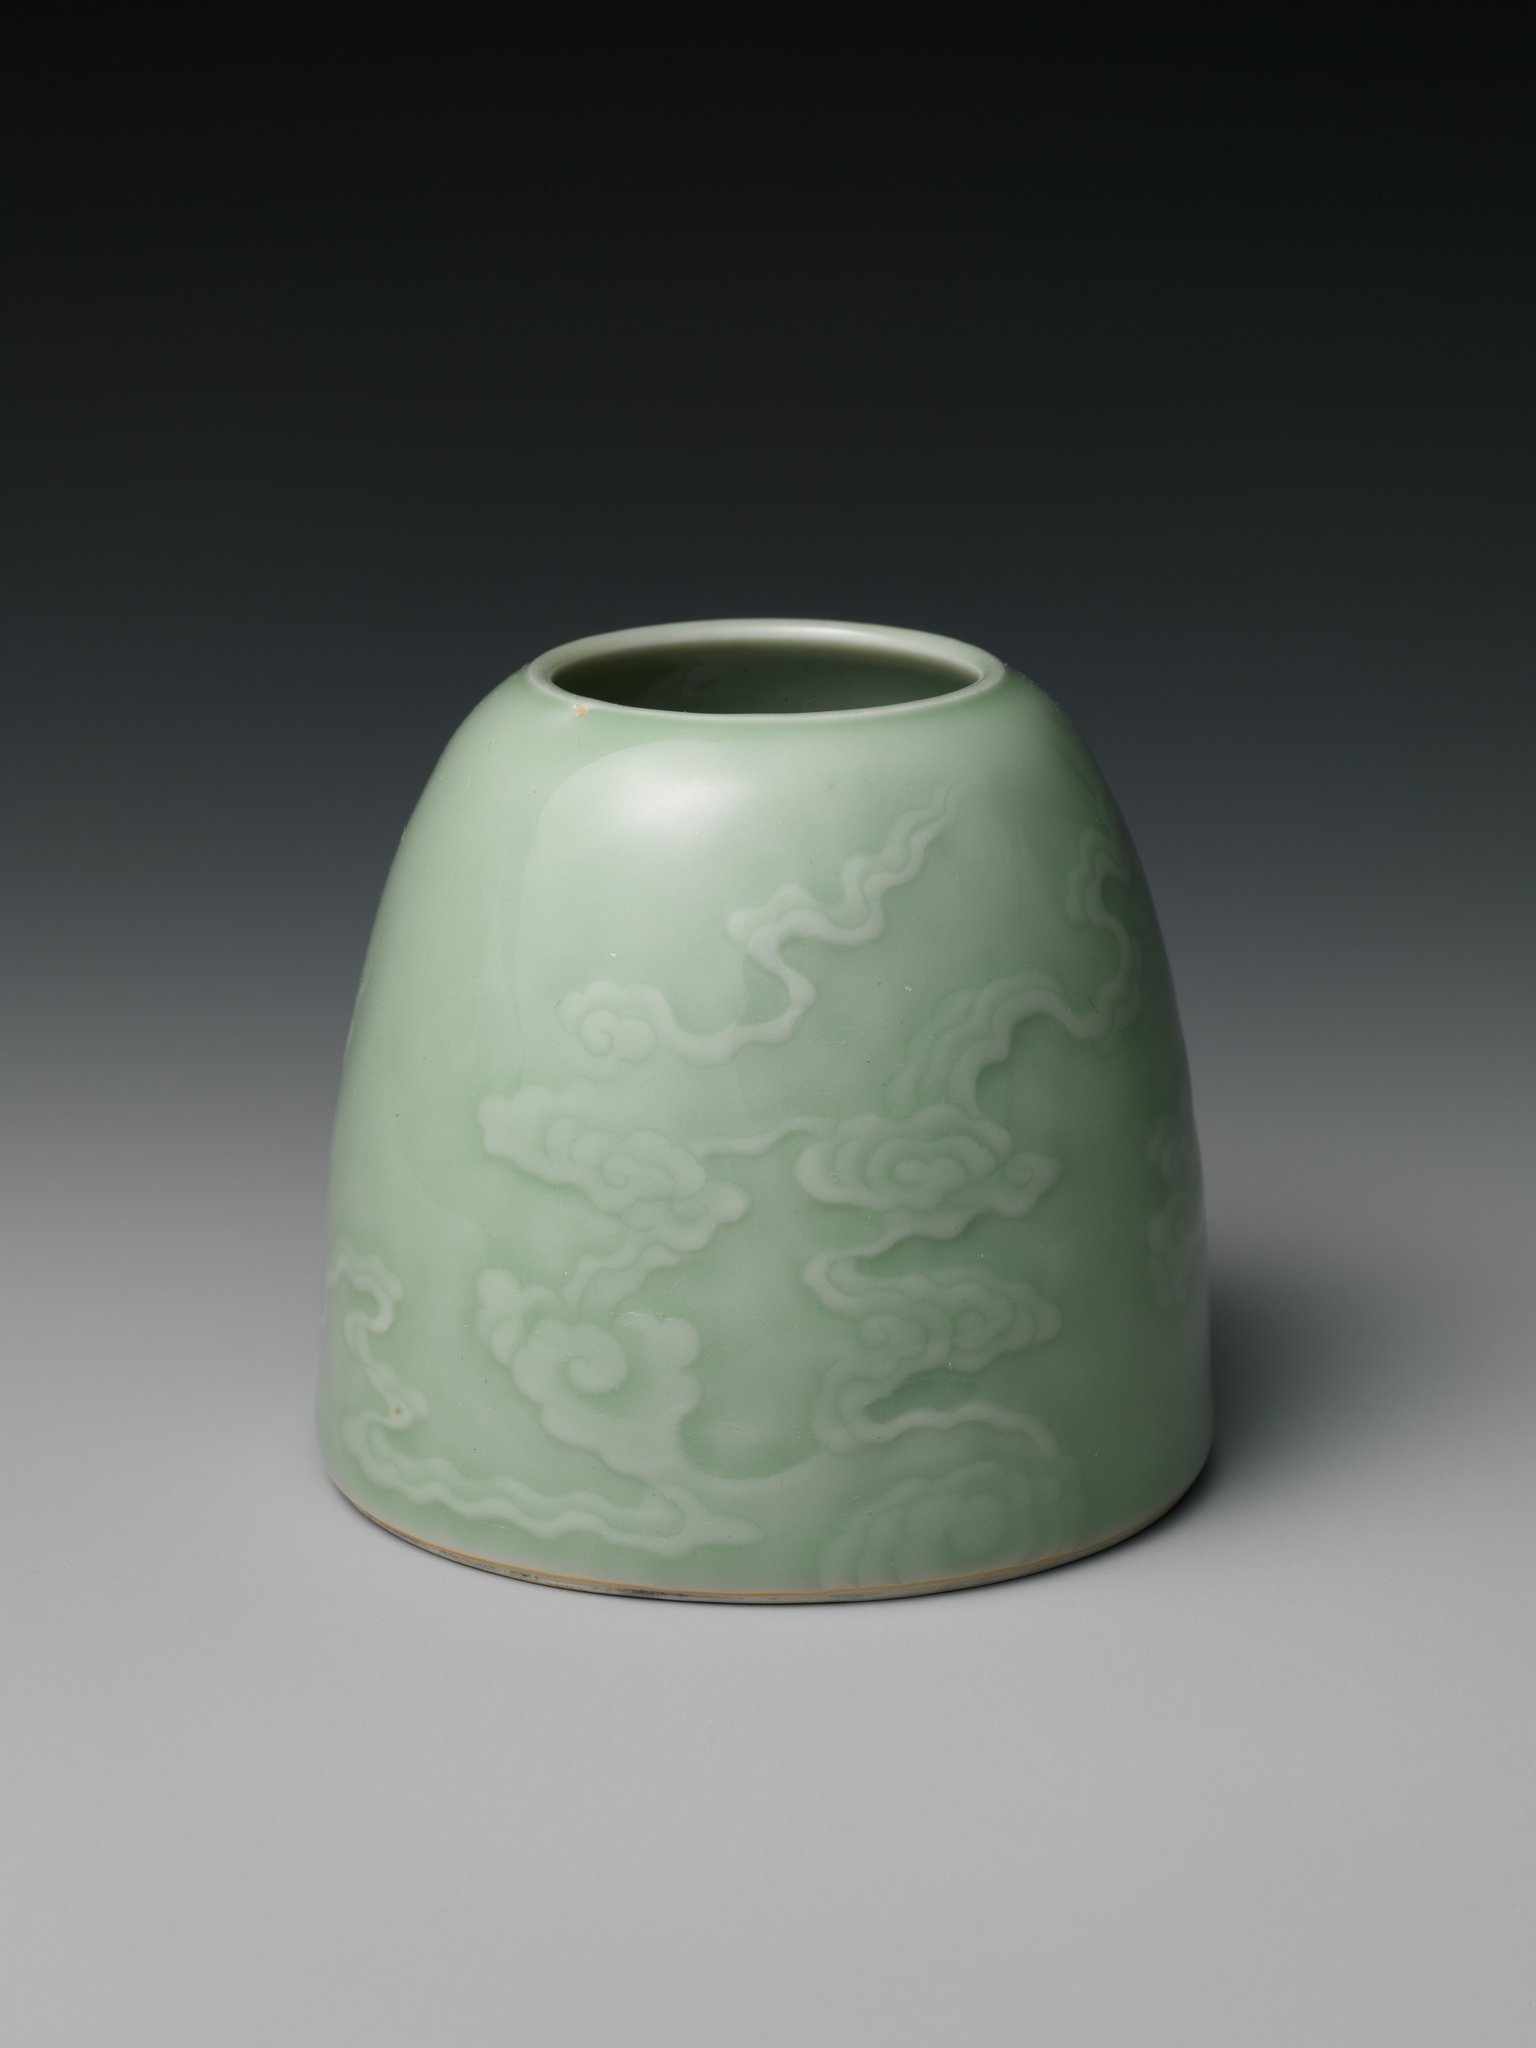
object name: water jar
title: Water jar with clouds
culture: chinese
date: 1662-1722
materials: ceramic glaze, glaze, porcelain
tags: clouds